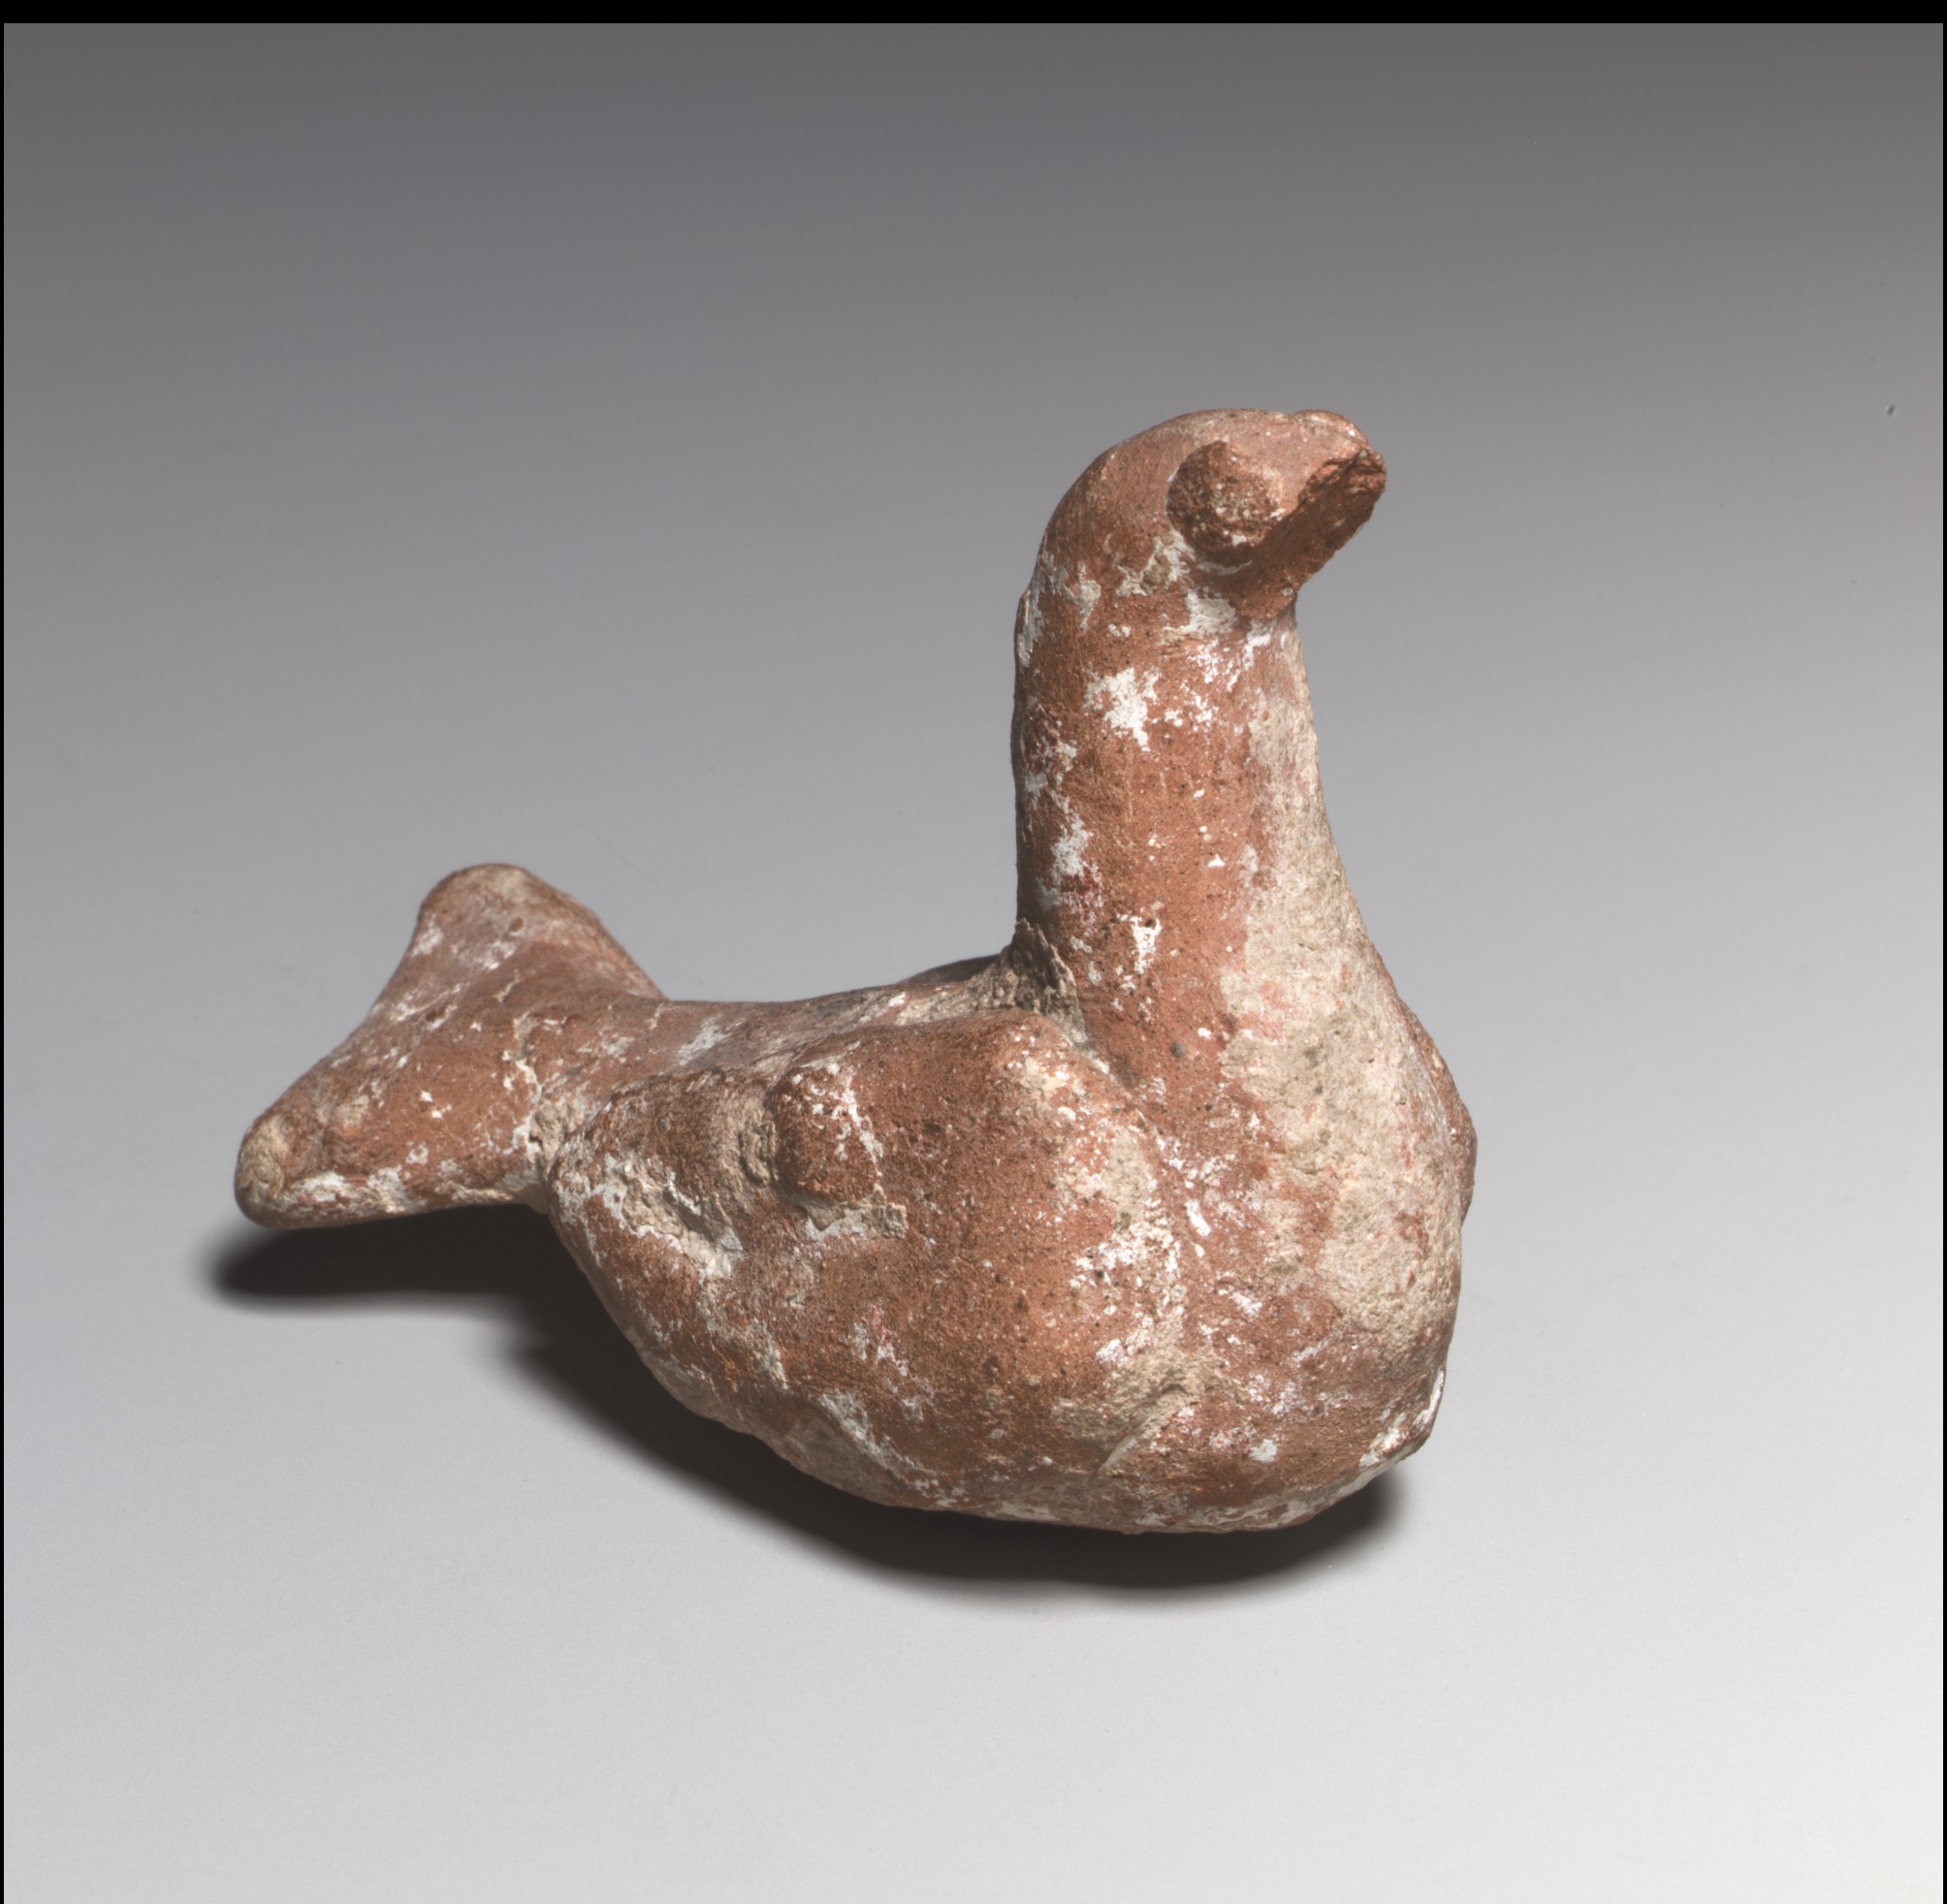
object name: statuette of a bird dove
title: Statuette of a bird (dove)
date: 507-323 BCE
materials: terracotta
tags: doves